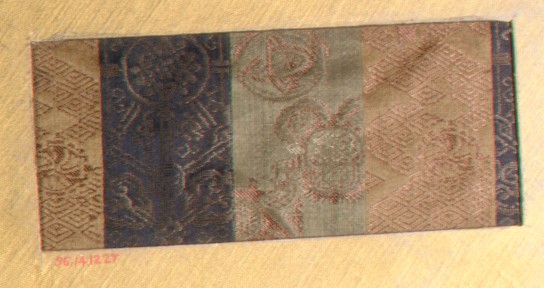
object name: piece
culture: japanese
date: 1701-1900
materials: silk